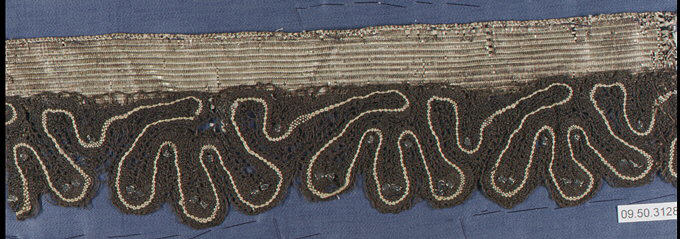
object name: piece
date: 1801-1900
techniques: lace